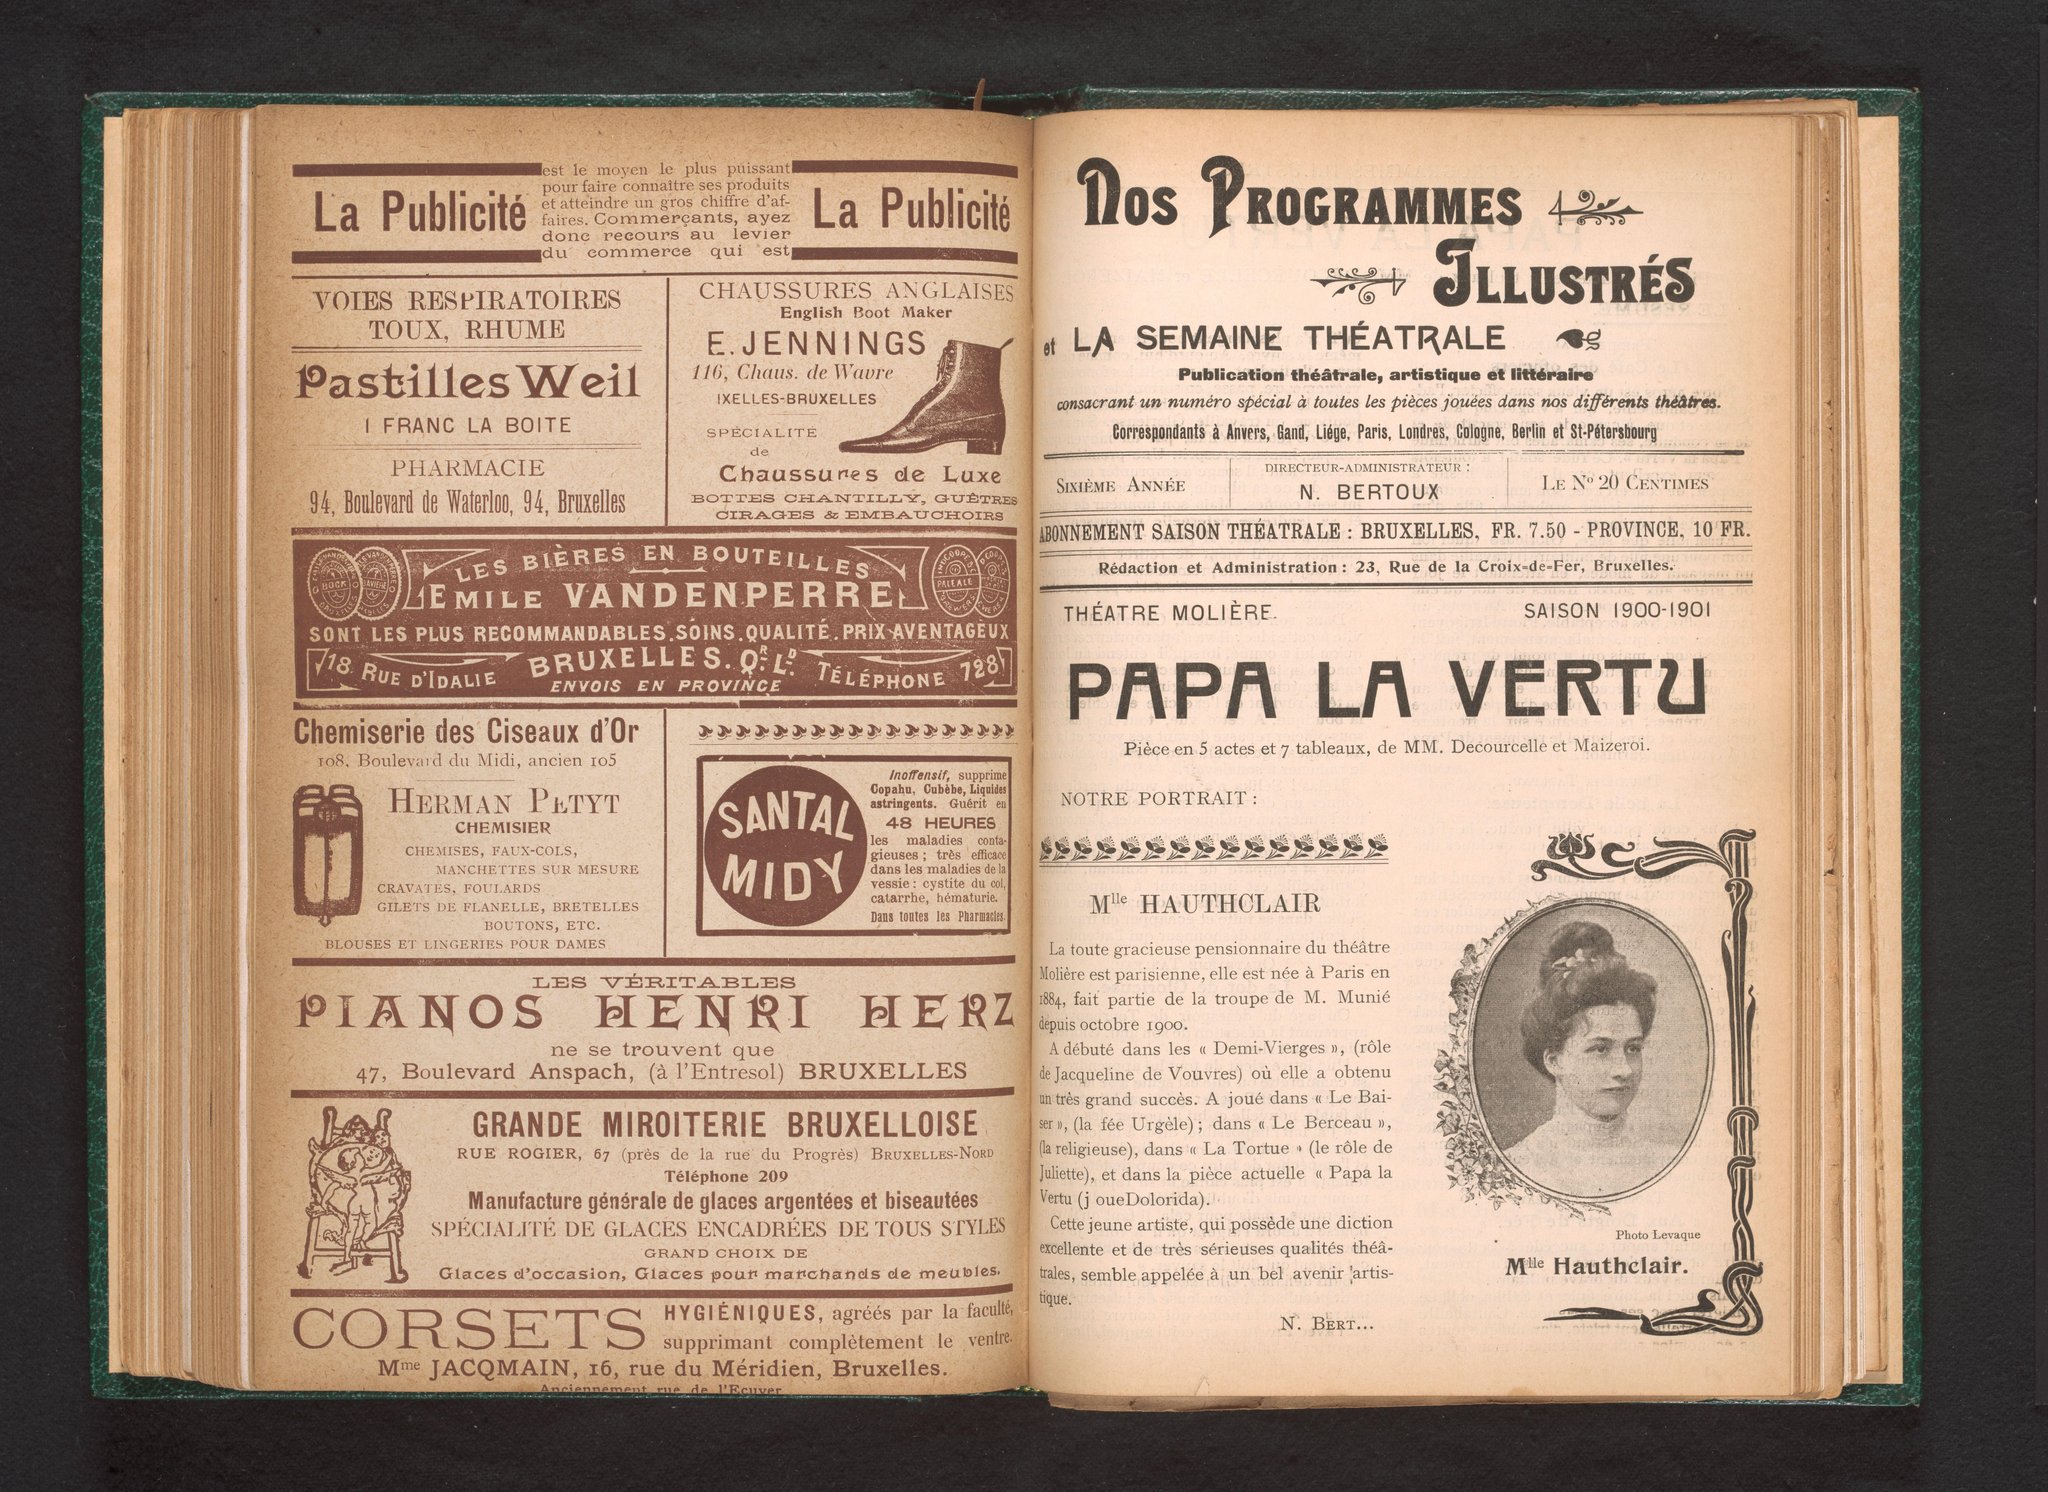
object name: photomechanical print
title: Mlle Hauthclair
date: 1895-1900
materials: paper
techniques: autotype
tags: adult man, historical persons